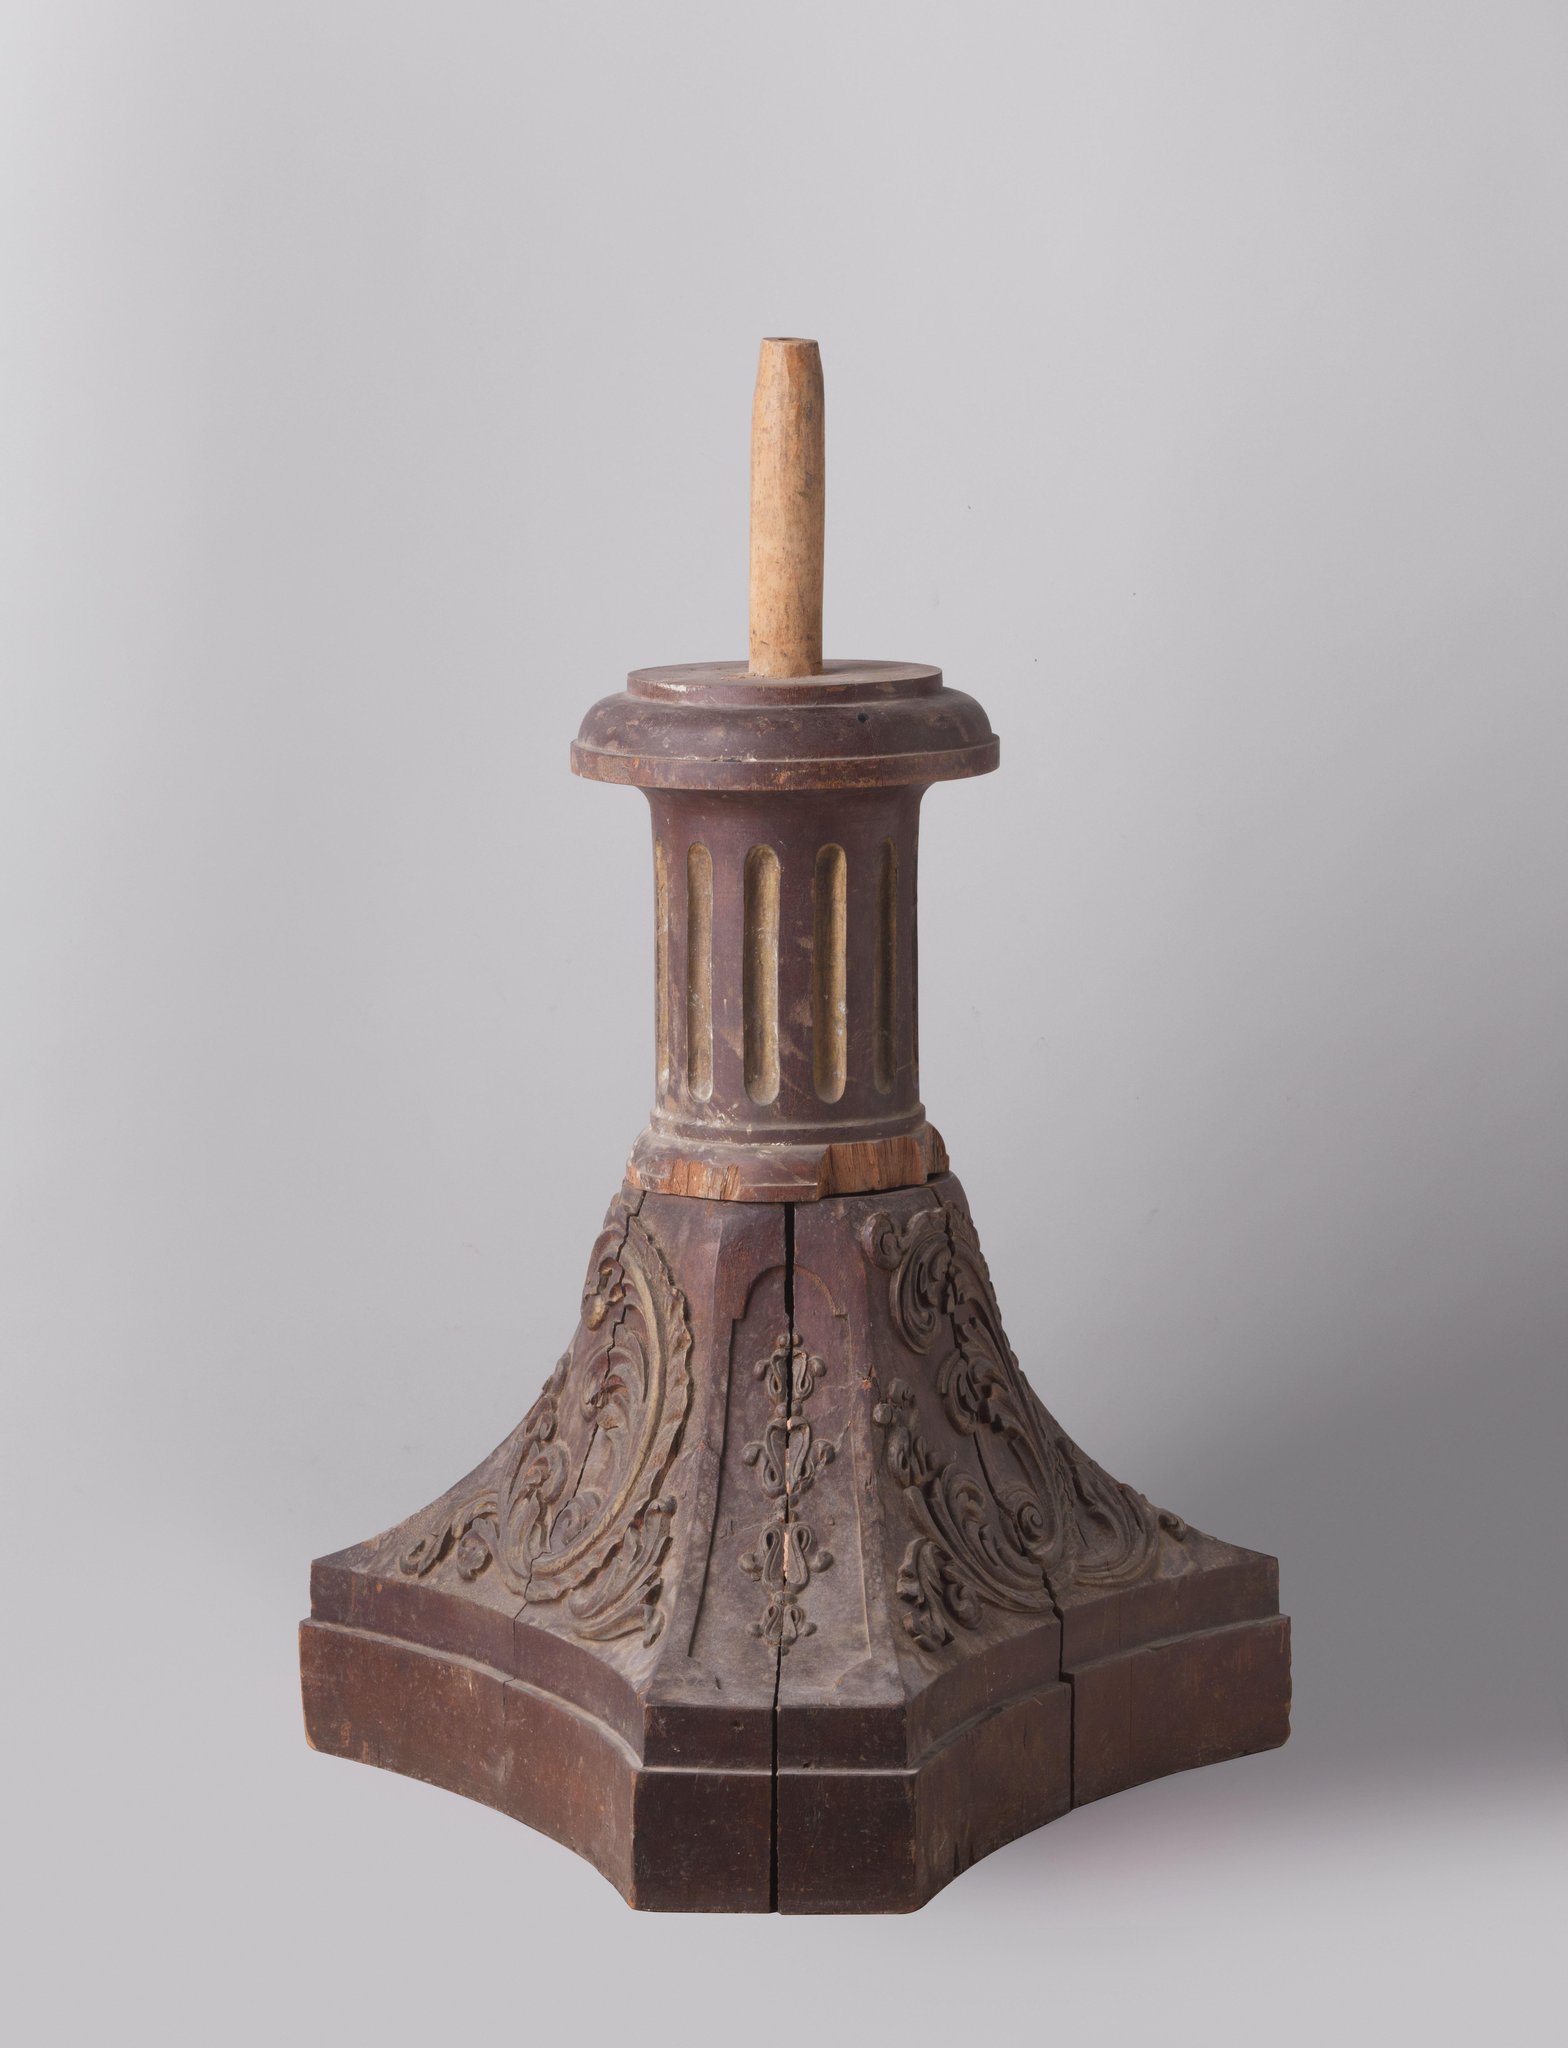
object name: base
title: Voetstuk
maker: Anonymous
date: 1900-1910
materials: iron, wood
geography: netherlands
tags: netherlands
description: Voetstuk met acht hoeken, versierd met lofwerk.